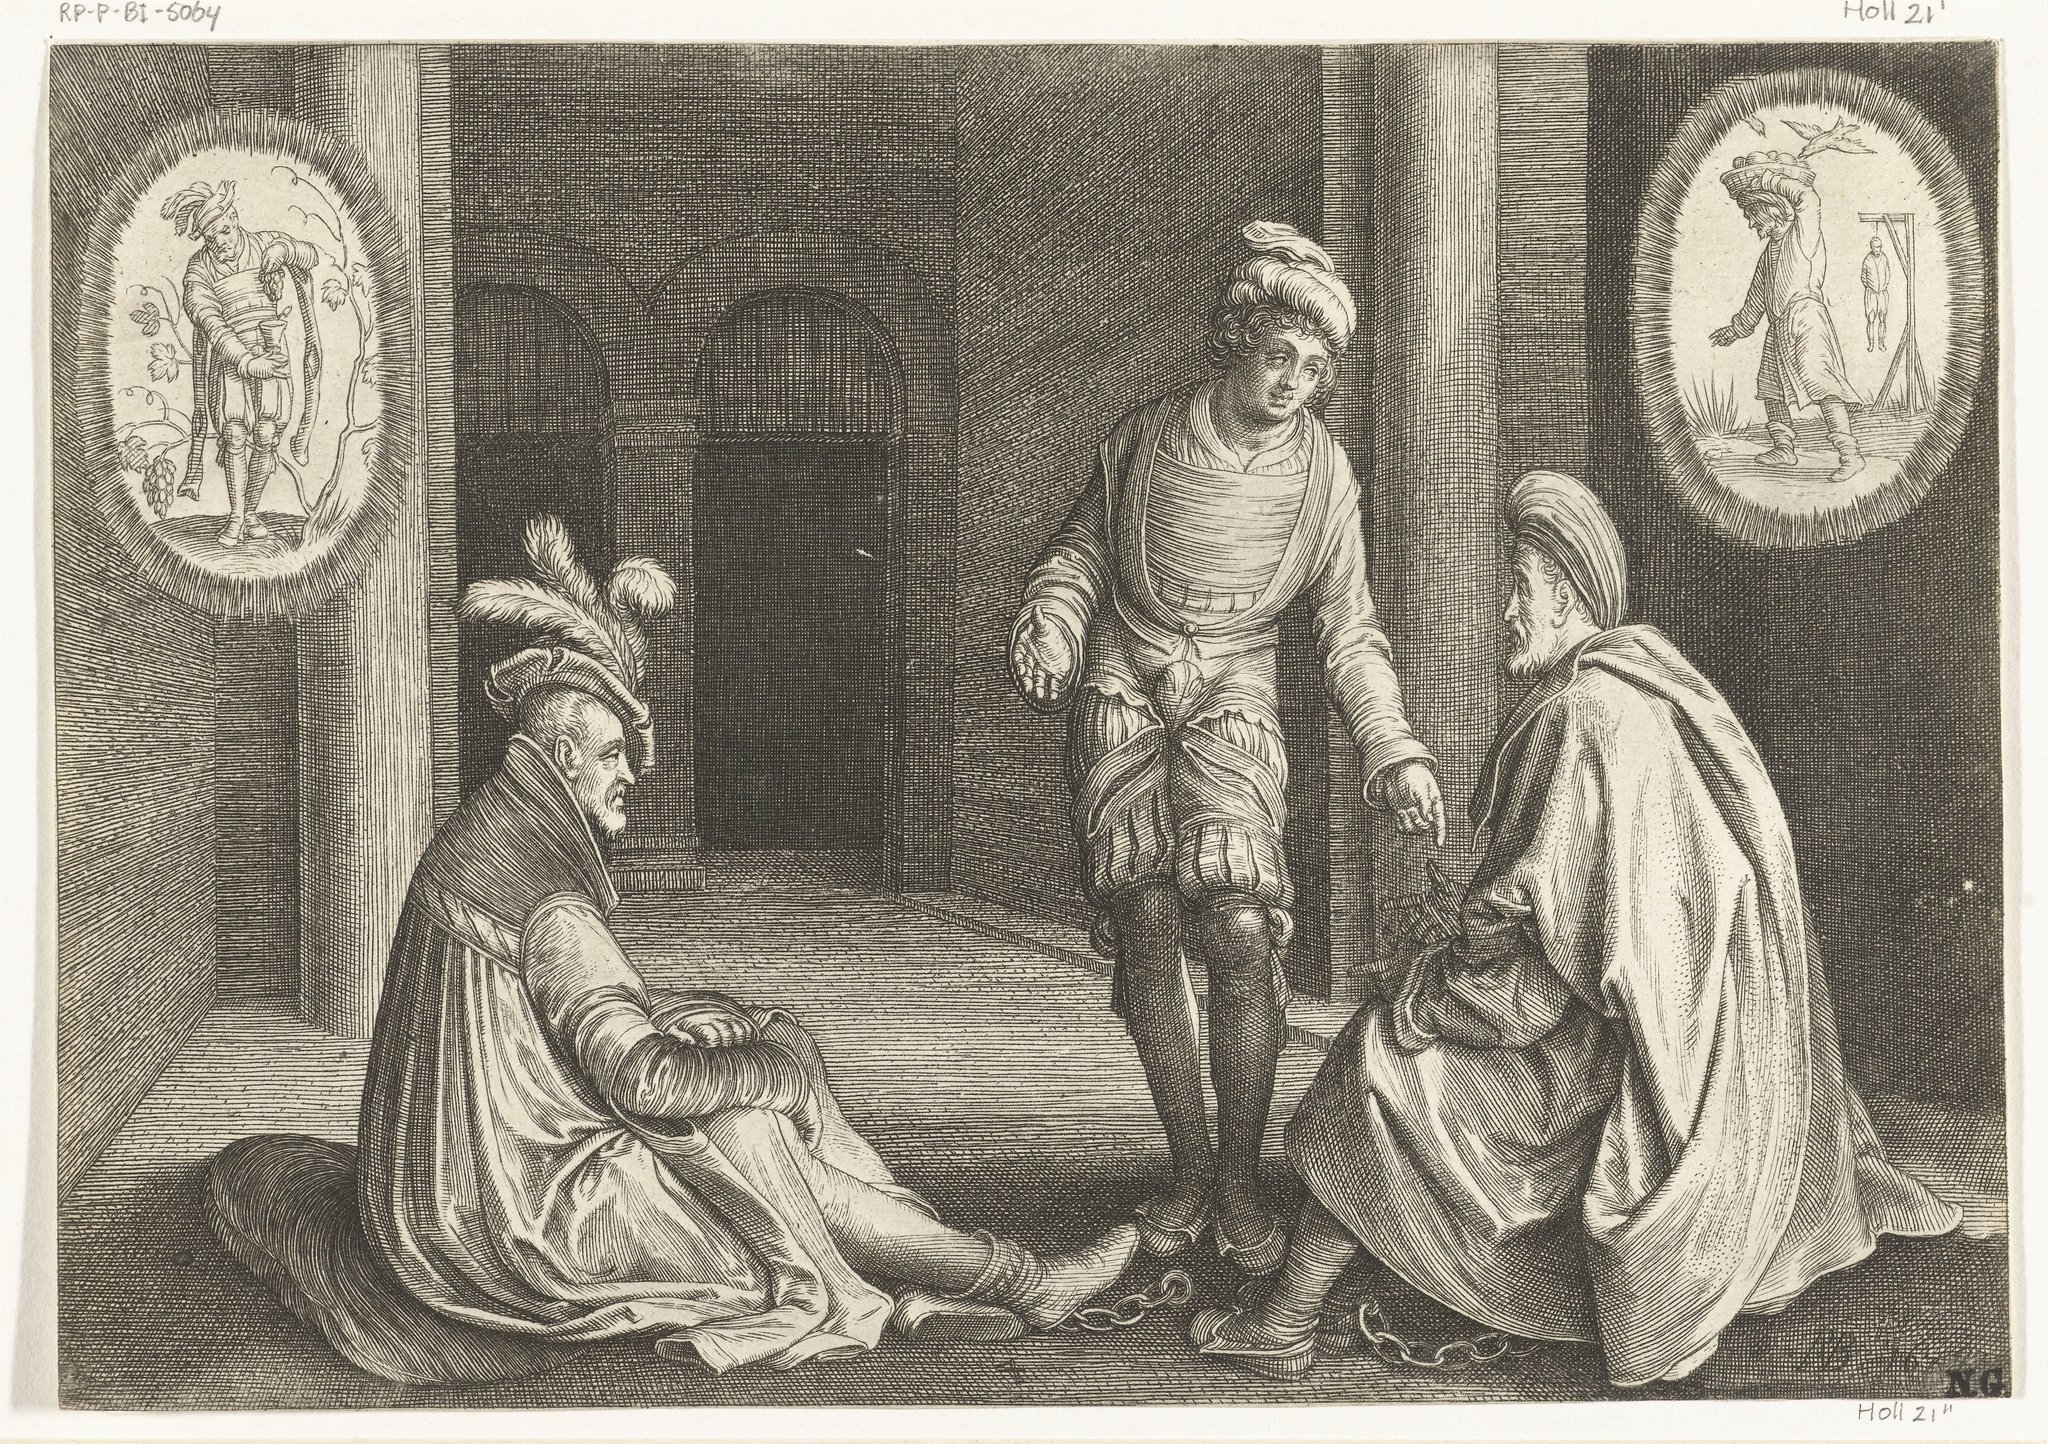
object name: print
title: Verhaal van Jozef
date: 1628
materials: paper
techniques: engraving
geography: netherlands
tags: joseph interpreting the dreams of the butler and the baker (the two dreams combined)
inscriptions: collector's mark: Lugt 1967, collector's mark: Lugt 2228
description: Prent uit serie van zes prenten met het verhaal van Jozef. De serie is geïnspireerd op een vergelijkbare reeks van Lucas van Leyden.